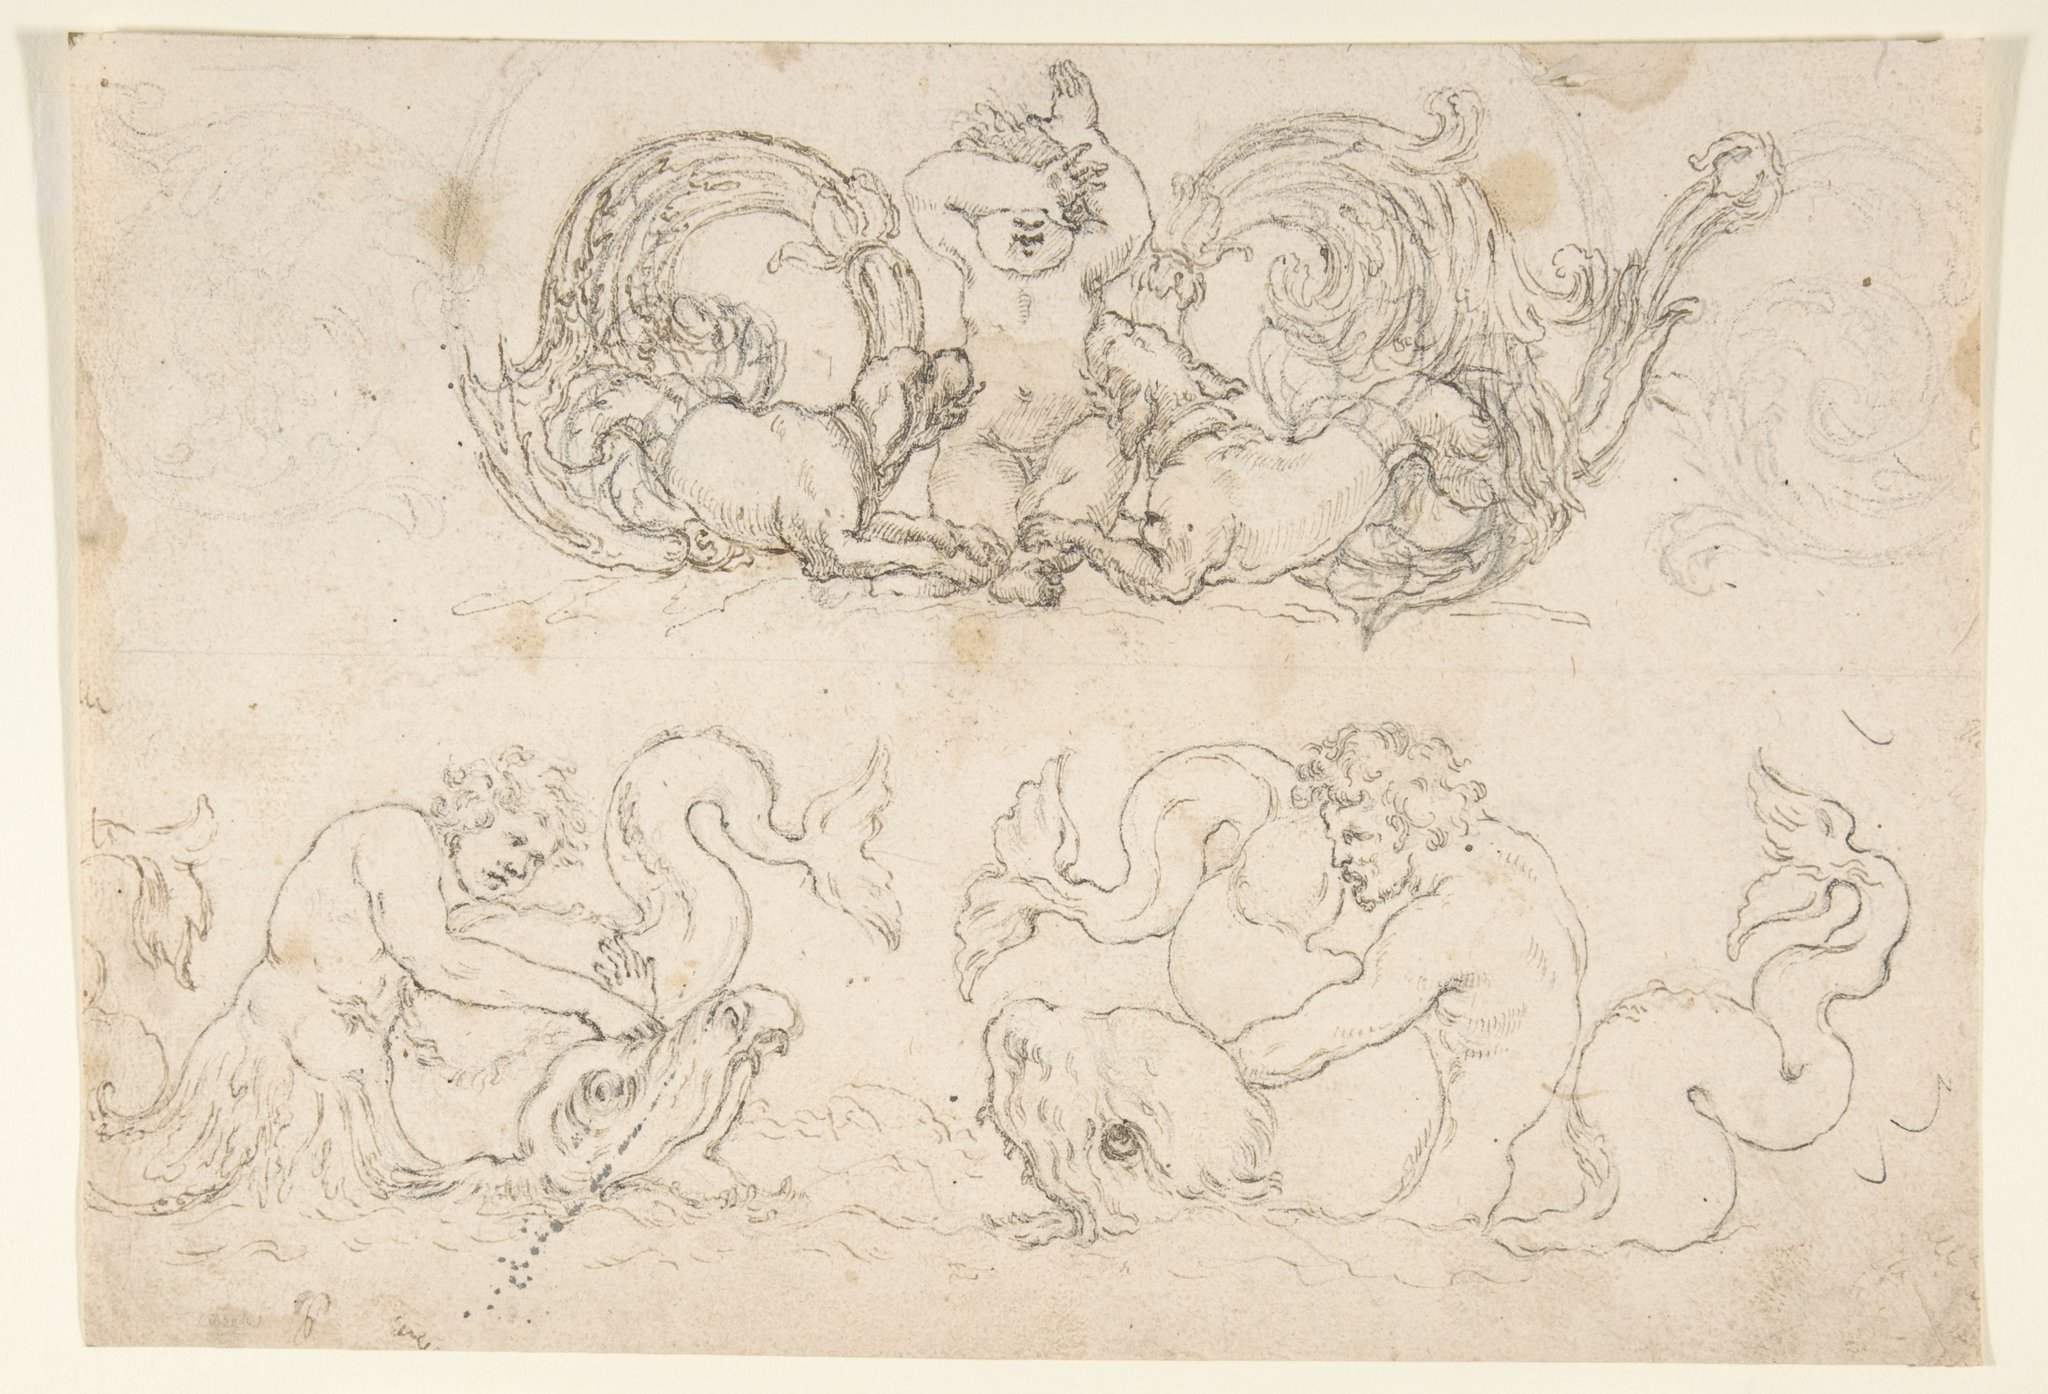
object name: drawing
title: Designs for Ornamental Motifs with Figures, Real and Imaginary Animals, and Coats of Arms of the Medici Grand Dukes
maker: stefano della bella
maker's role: artist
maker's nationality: italian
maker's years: 1610-1664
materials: chalk, ink, drawing material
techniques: pen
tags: animals,mythical creatures,dogs,coat of arms